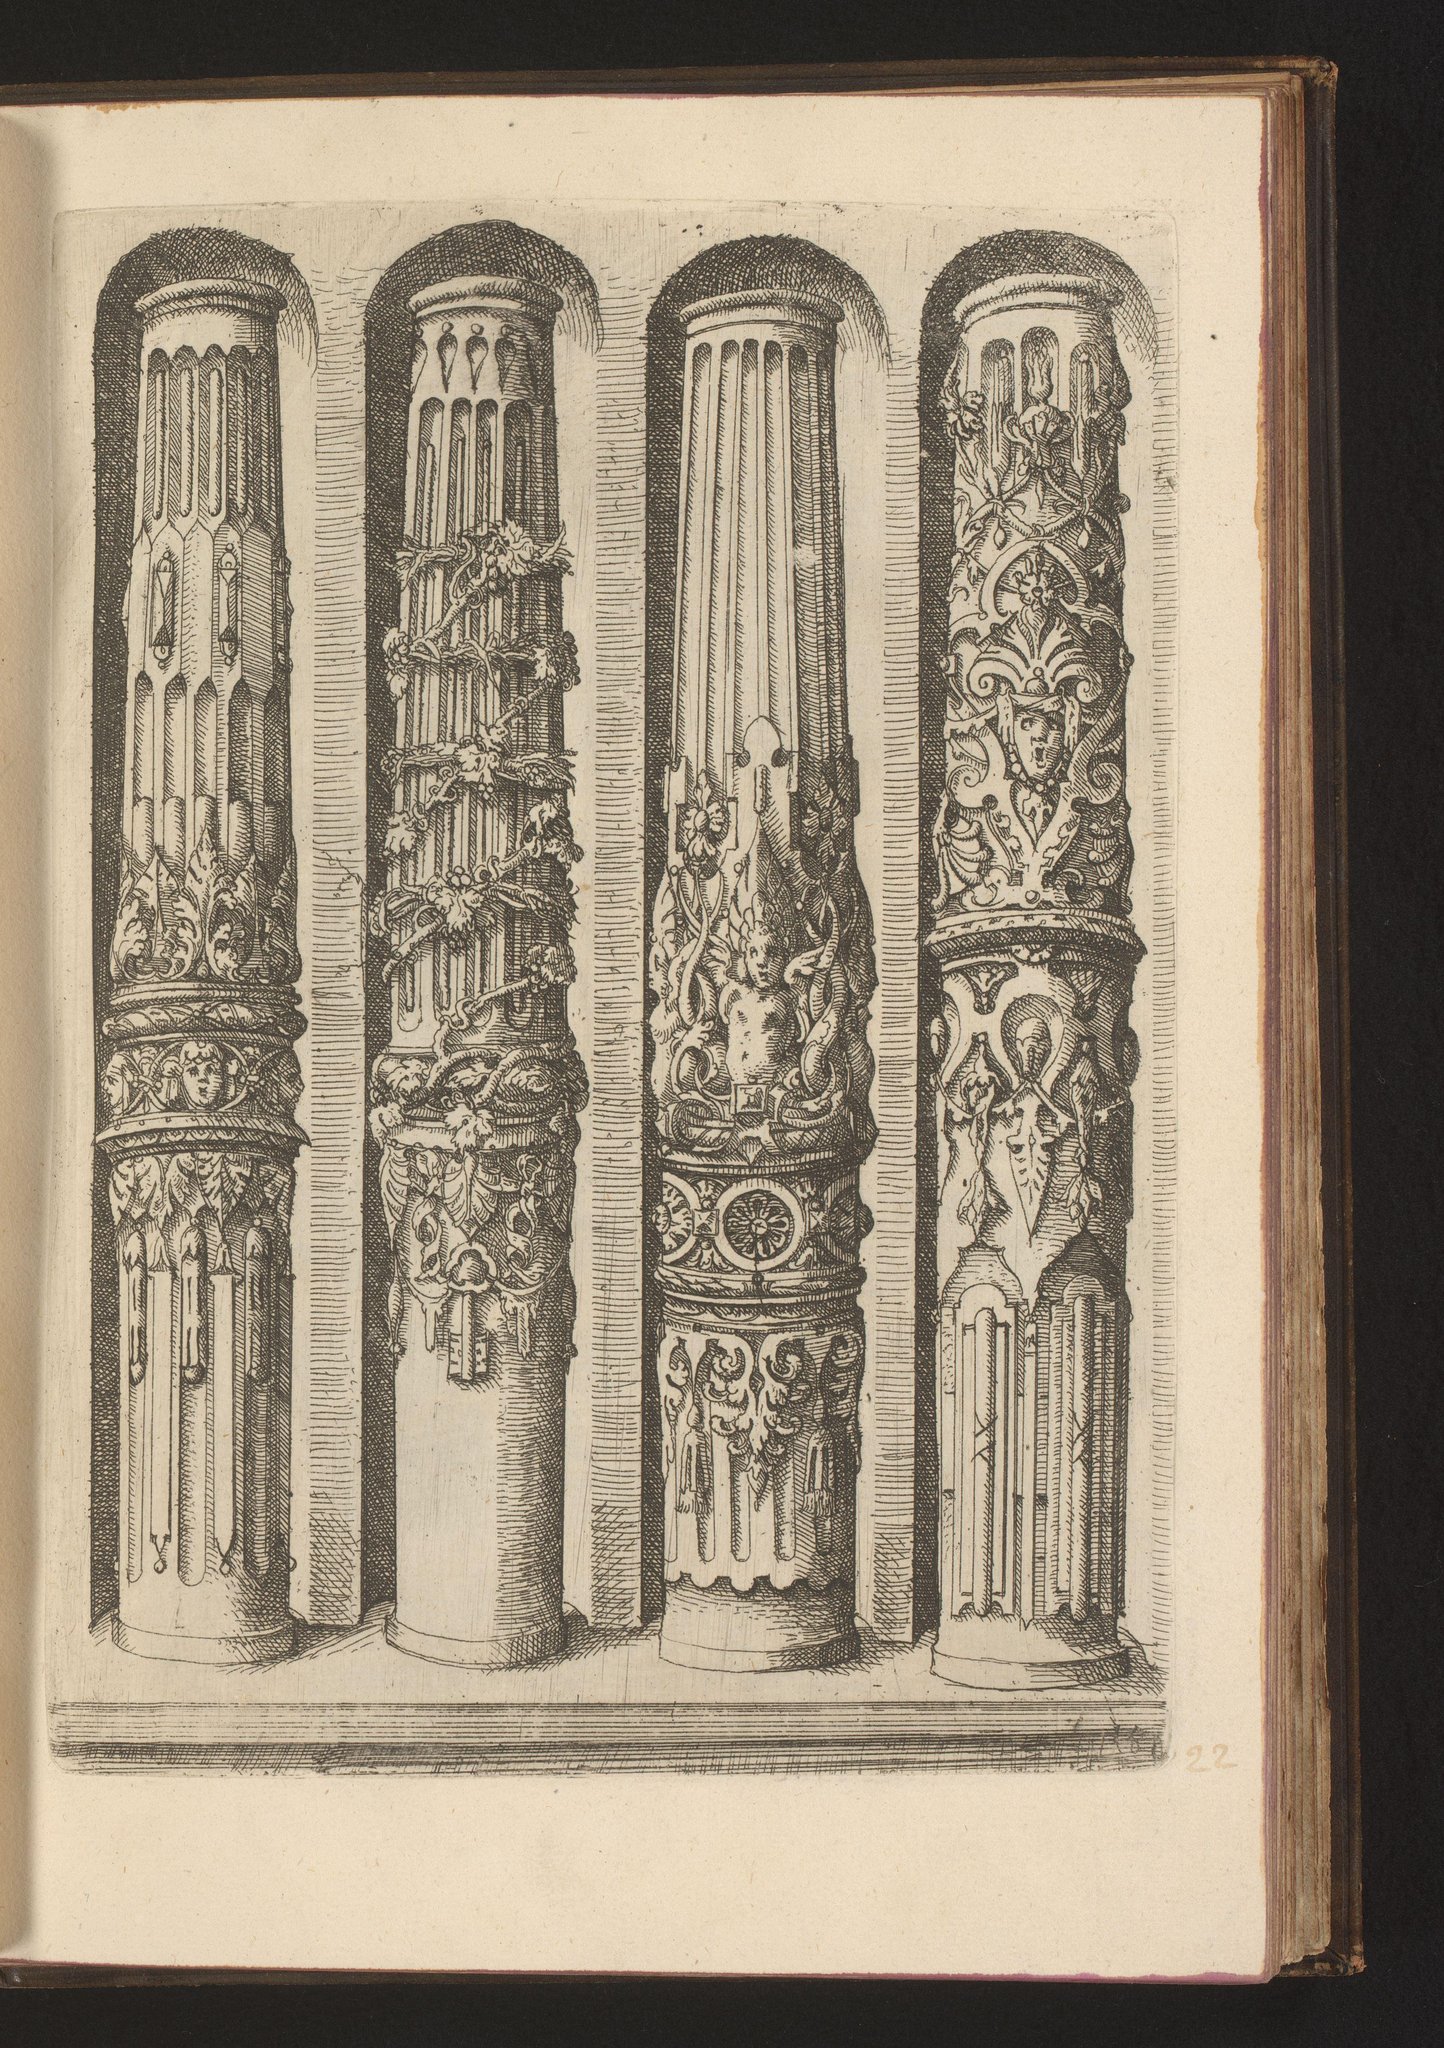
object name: page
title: Architectura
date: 1593-1595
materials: paper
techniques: etching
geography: straatsburg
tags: column, pillar ~ architecture, monsters of mixed human and animal shape; 'mostri' (ripa), 'laub- und bandelwerk' ~ ornament, other architectural details, ionic order ~ architecture, foliage, tendrils, branches ~ ornament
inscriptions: collector's mark: Lugt 2760, collector's mark: Lugt 2228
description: Prent gebruikt in: Dietterlin, Wendel (I). Architectura de quinq[ue] columnarum simmetrica distributione et variis eorundem or namentis: Liber I. Straatsburg: Bernhard Jobin, 1593.